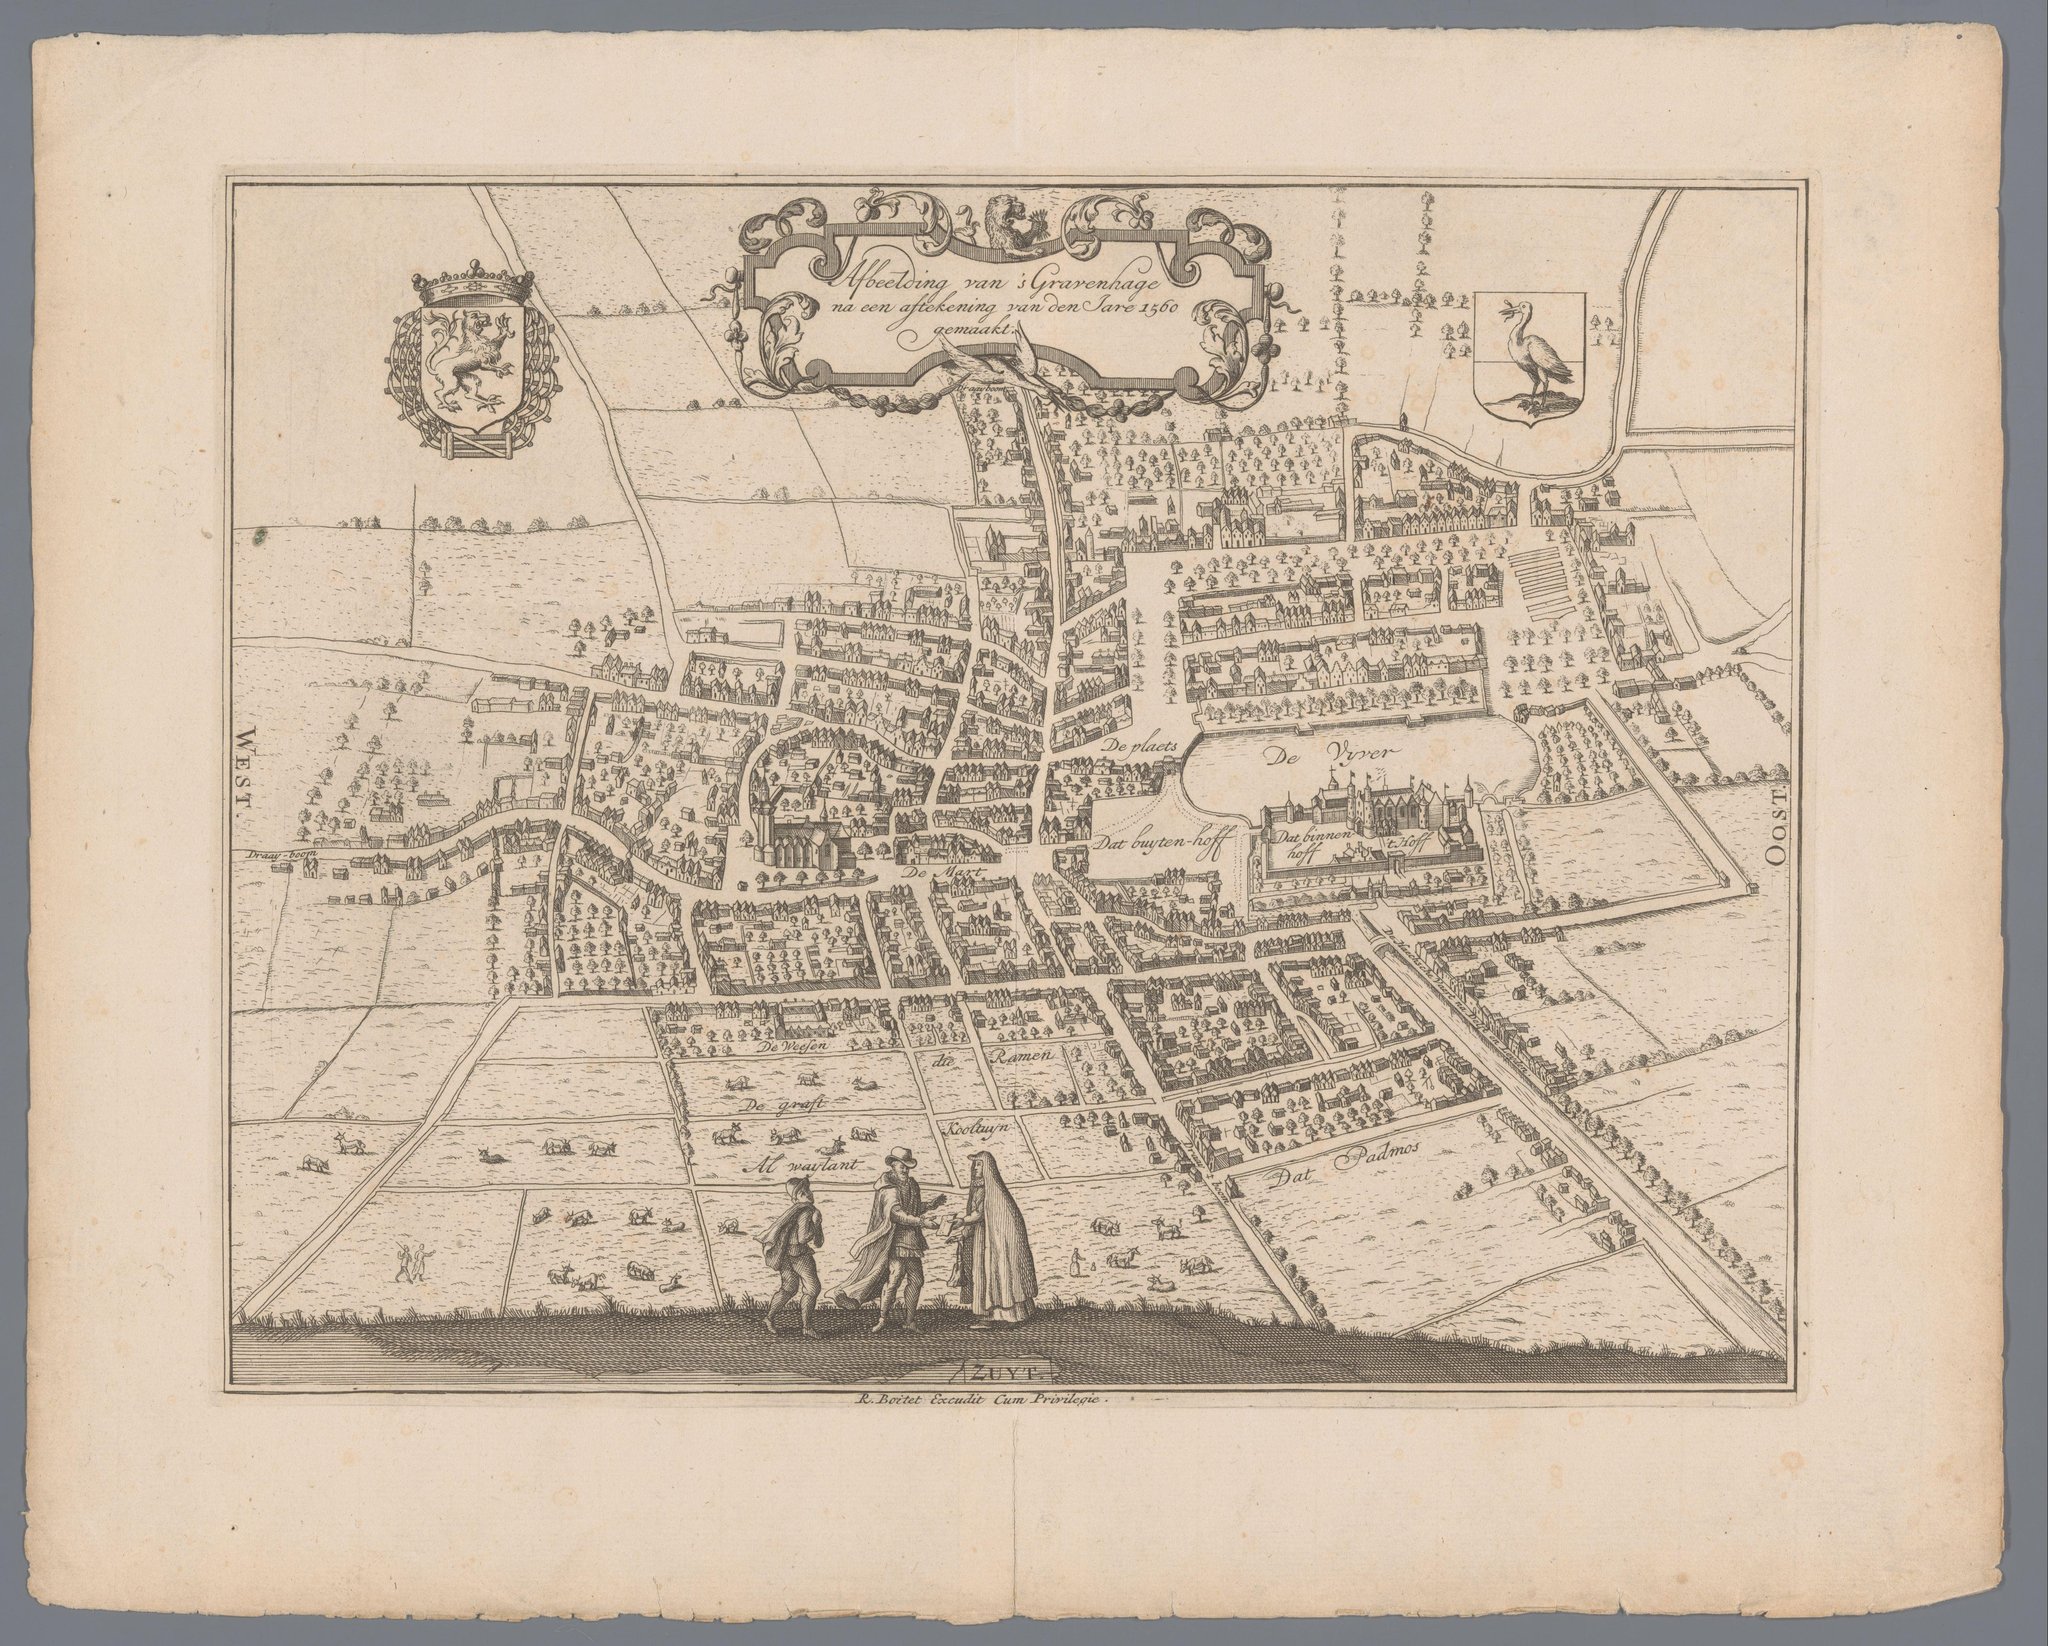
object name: area plan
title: Plattegrond van Den Haag, 1560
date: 1730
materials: paper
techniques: engraving, etching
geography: delft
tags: coat of arms (as symbol of the state, etc.), maps of cities, the hague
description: Prent uit: Riemer, Jacob de. Beschryving van 's-Graven-Hage, behelzende deszelfs oorsprong (...). 2 dln. Delft: Reinier Boitet, Den Haag: Johannes de Cros, 1730-1739, dl. 1.1, p. 84-85.